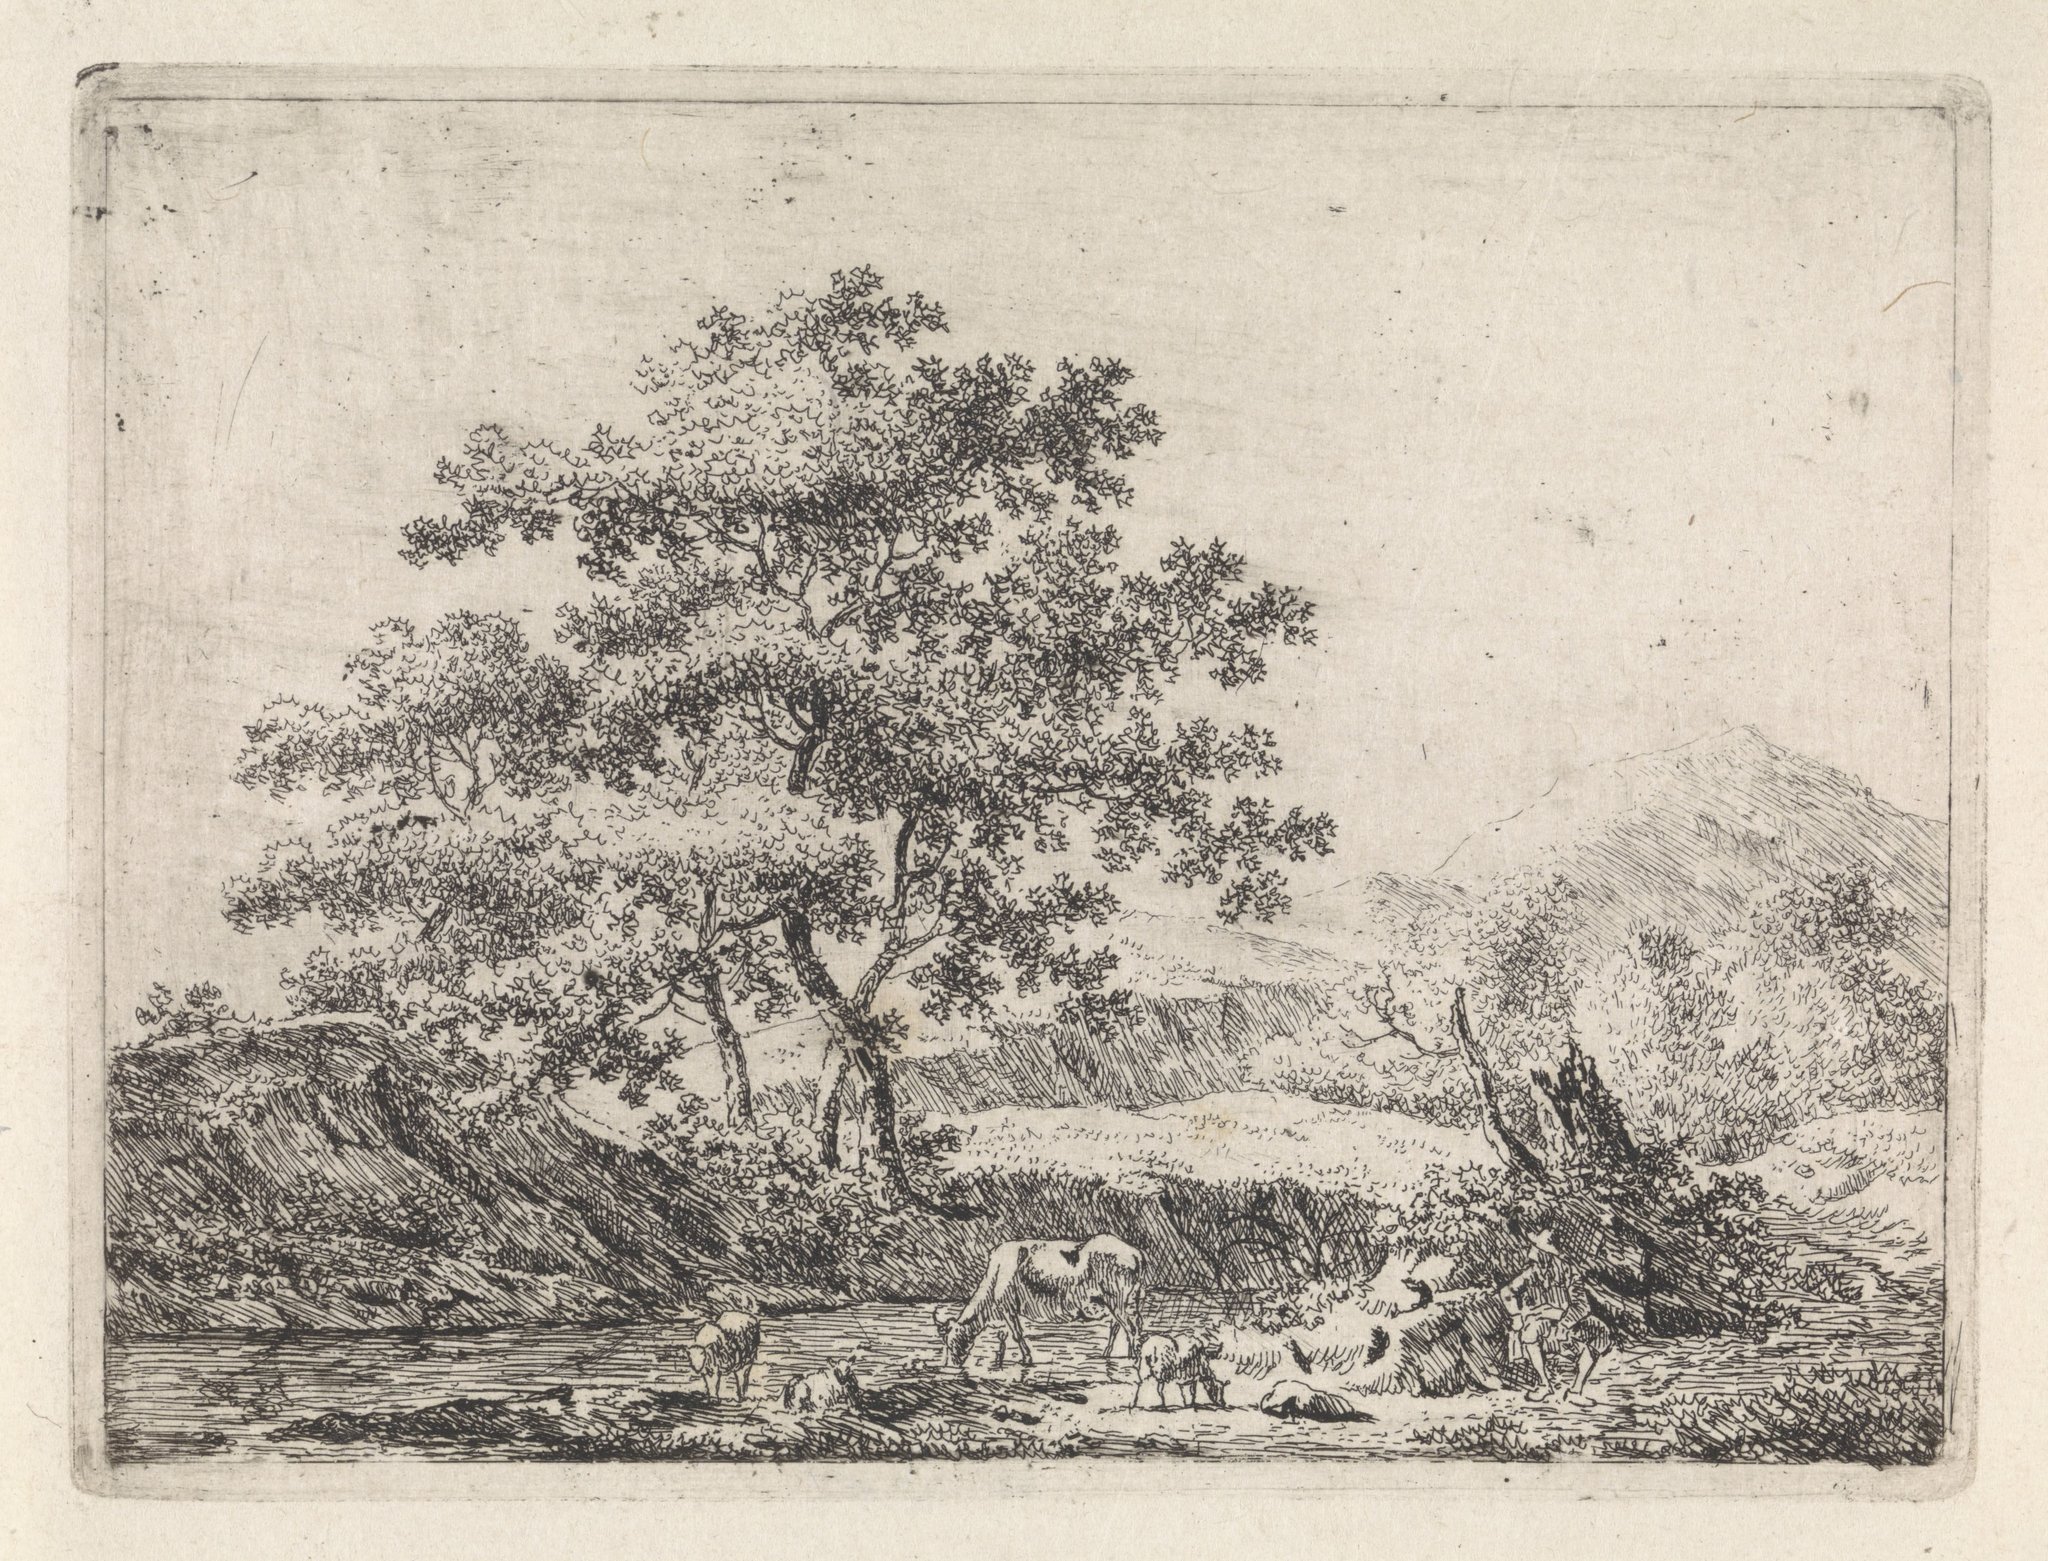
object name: print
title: Herder met vee bij rivier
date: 1761-1823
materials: paper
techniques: etching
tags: cow, landscapes (+ landscape with figures, staffage)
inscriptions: collector's mark: Lugt 240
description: Heuvelachtig landschap met herder, zittend bij een rivier. Een koe drinkt uit de rivier. Vóór de lucht.